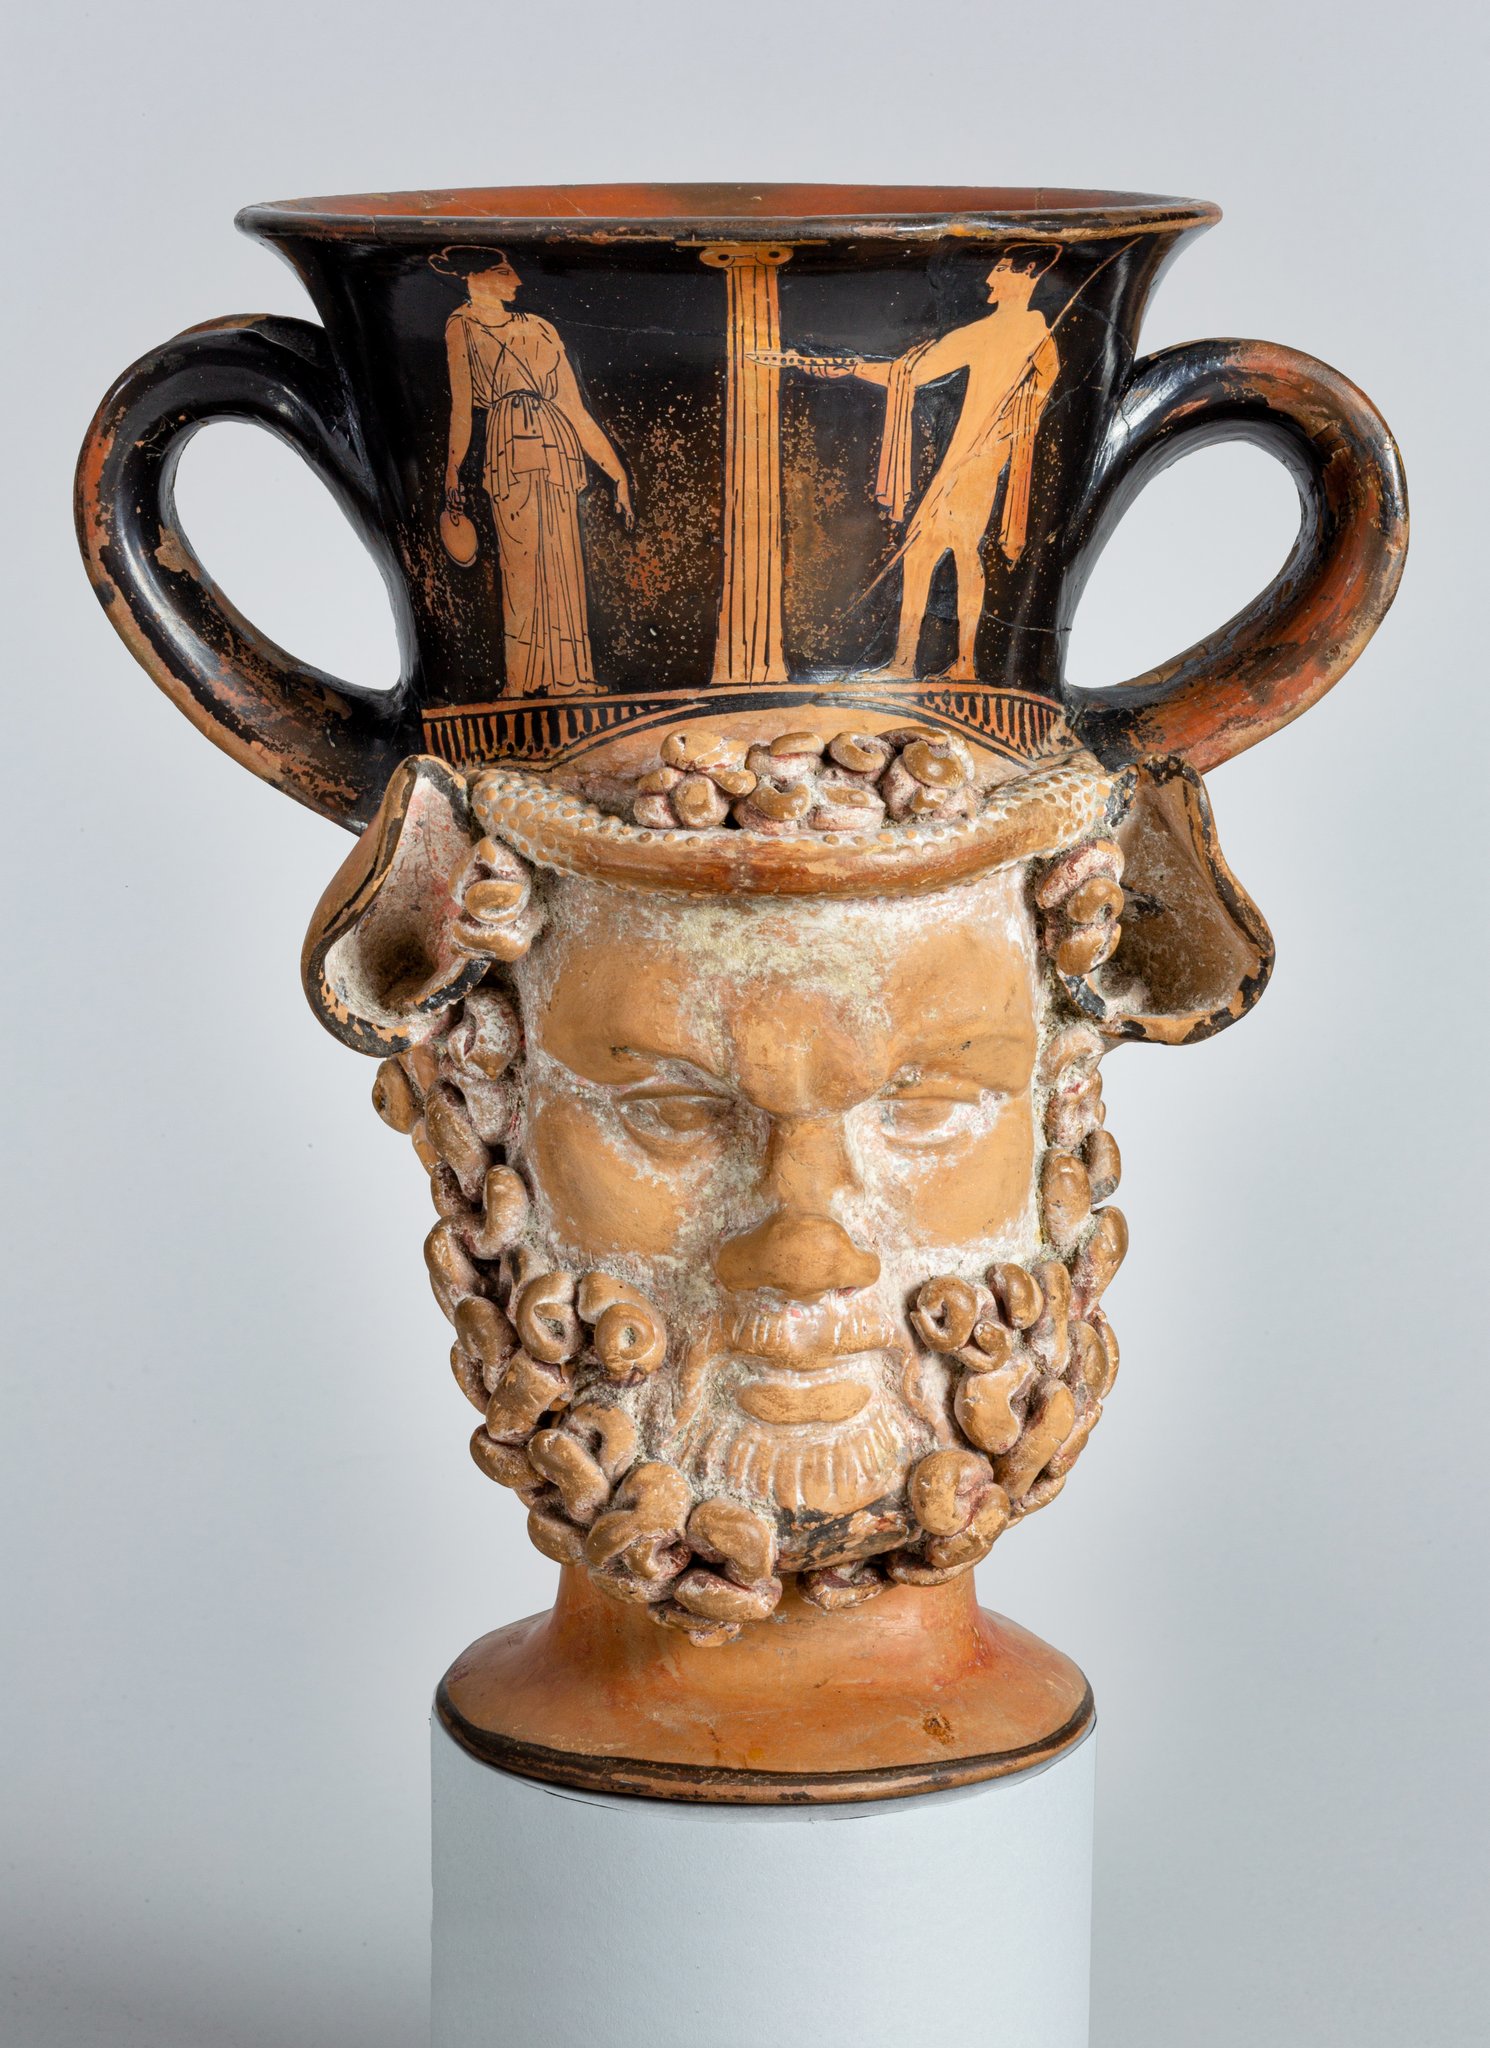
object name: kantharos in the form of the head of a satyr and a maenad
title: Terracotta kantharos (drinking cup with two vertical handles): heads of a satyr and a woman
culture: greek, attic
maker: aison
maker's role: artist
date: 420 BCE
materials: terracotta